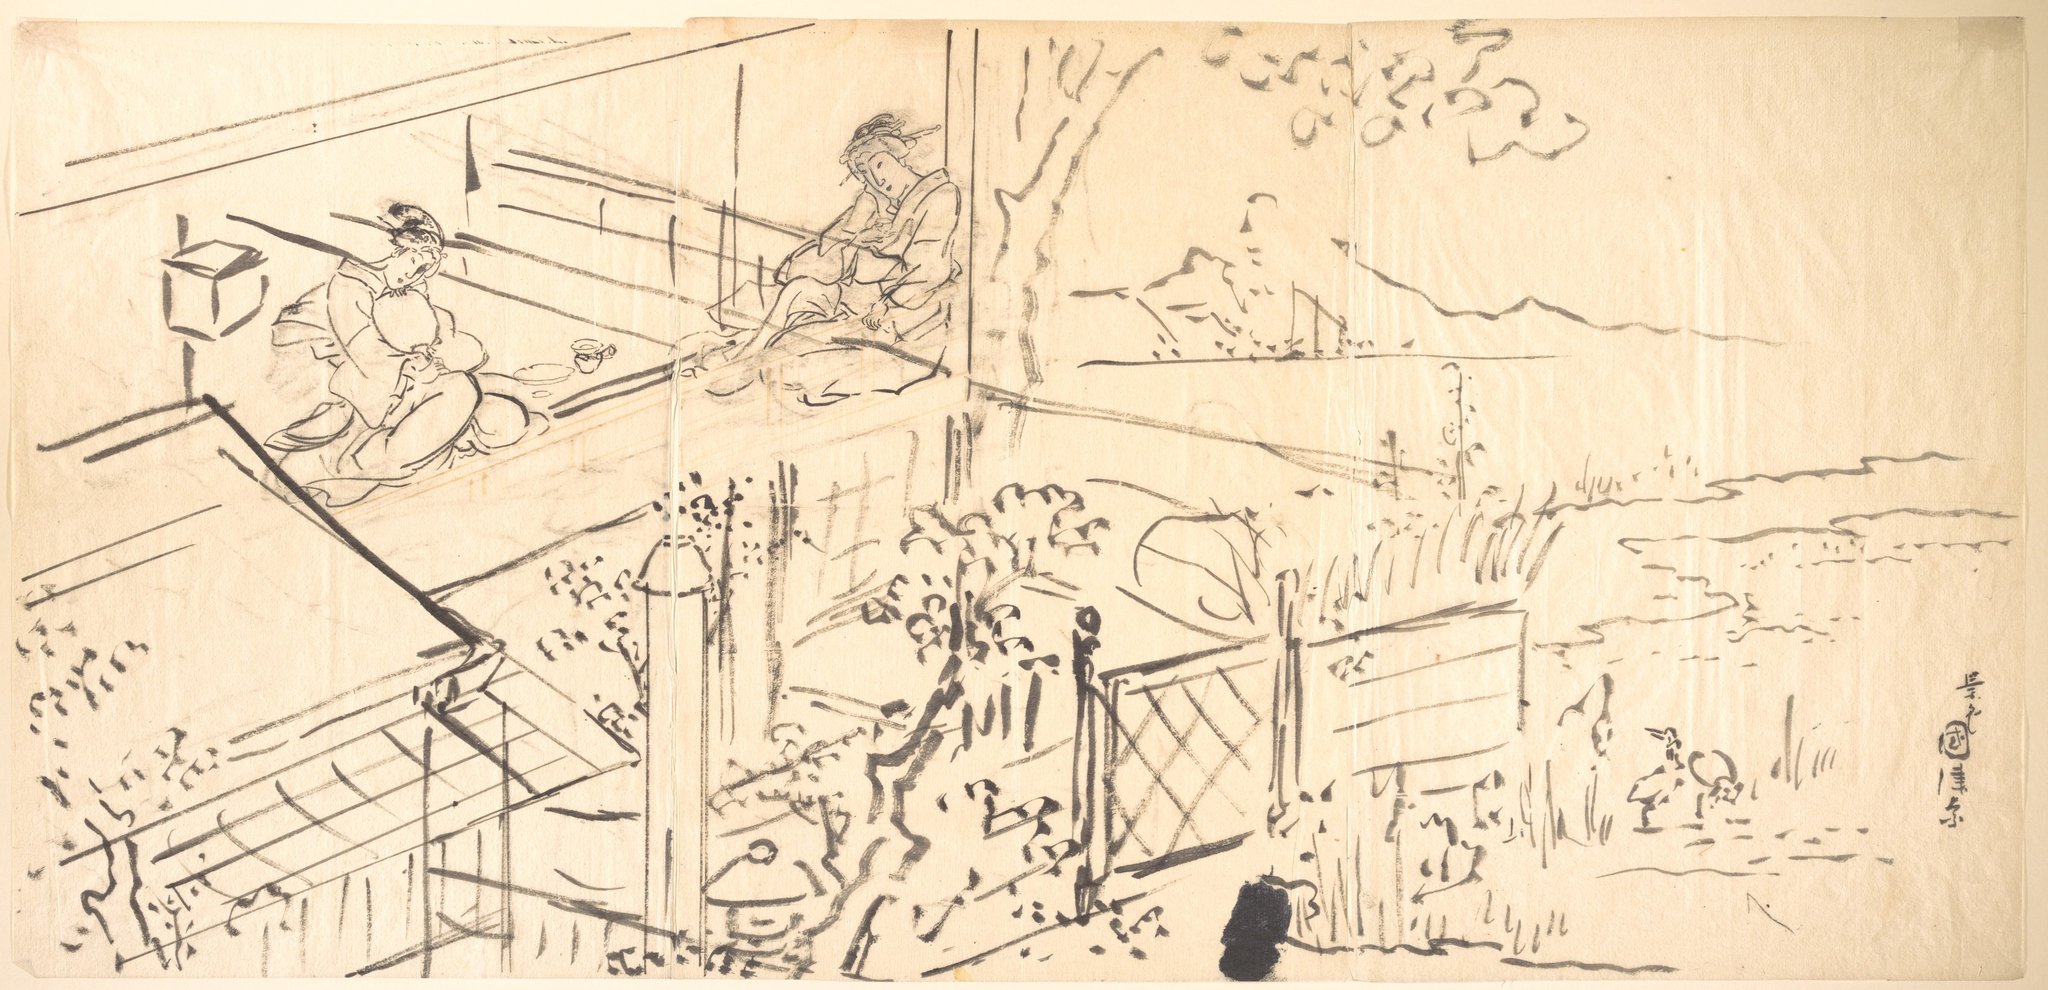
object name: print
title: Two Courtesans Enjoying the View from a Teahouse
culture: japanese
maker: utagawa kunisada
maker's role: artist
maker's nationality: japanese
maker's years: 1786-1864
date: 1786-1864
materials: ink, paper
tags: houses,women,trees